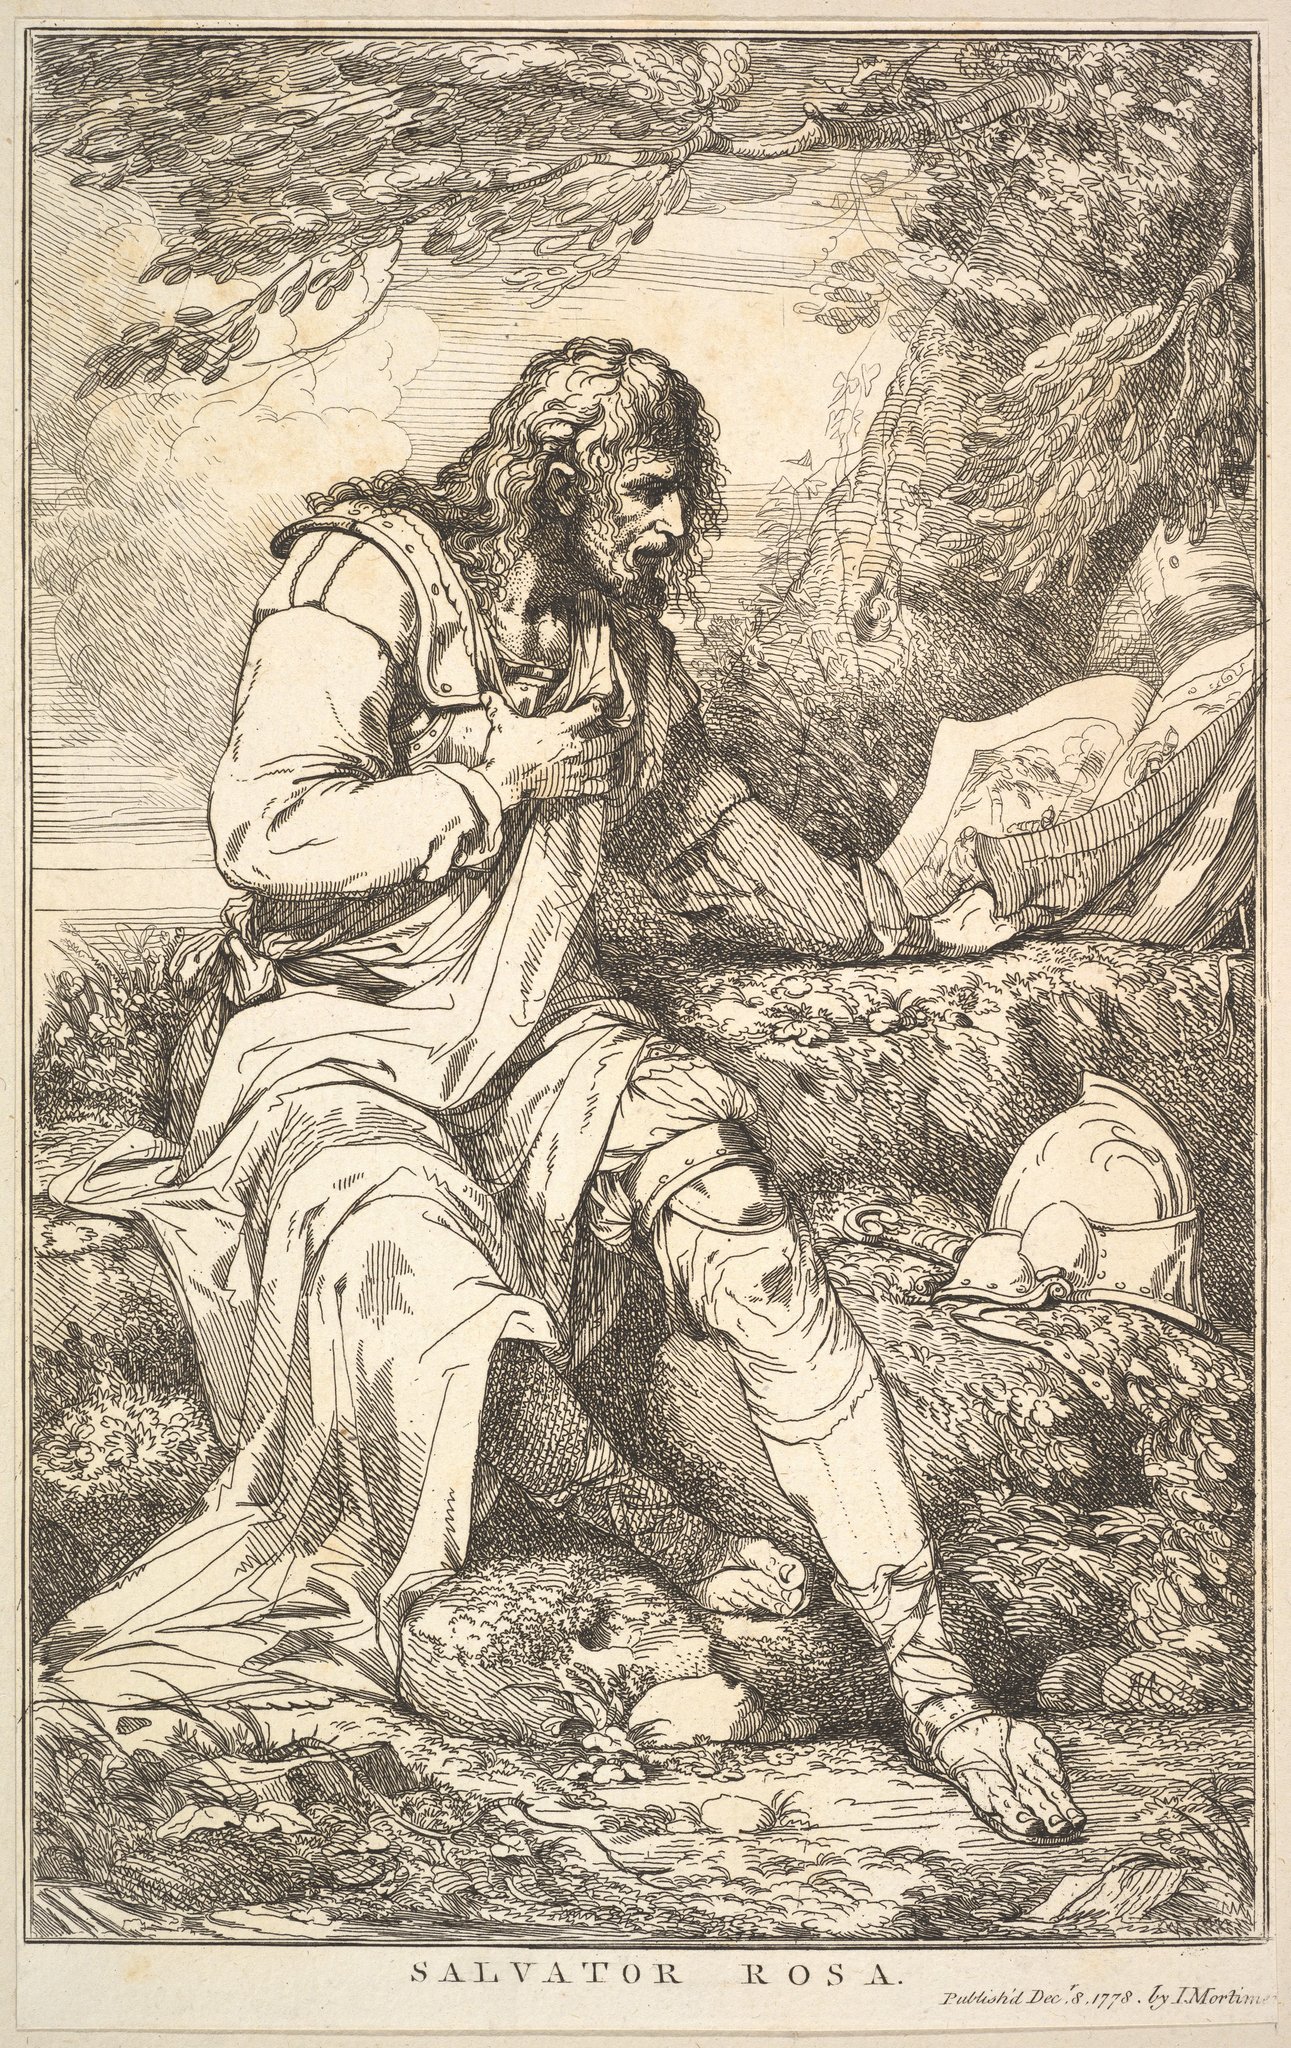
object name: print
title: Salvator Rosa, from "Fifteen Etchings Dedicated to Sir Joshua Reynolds"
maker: john hamilton mortimer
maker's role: artist and publisher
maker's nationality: british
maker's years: 1740-1779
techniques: etching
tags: men